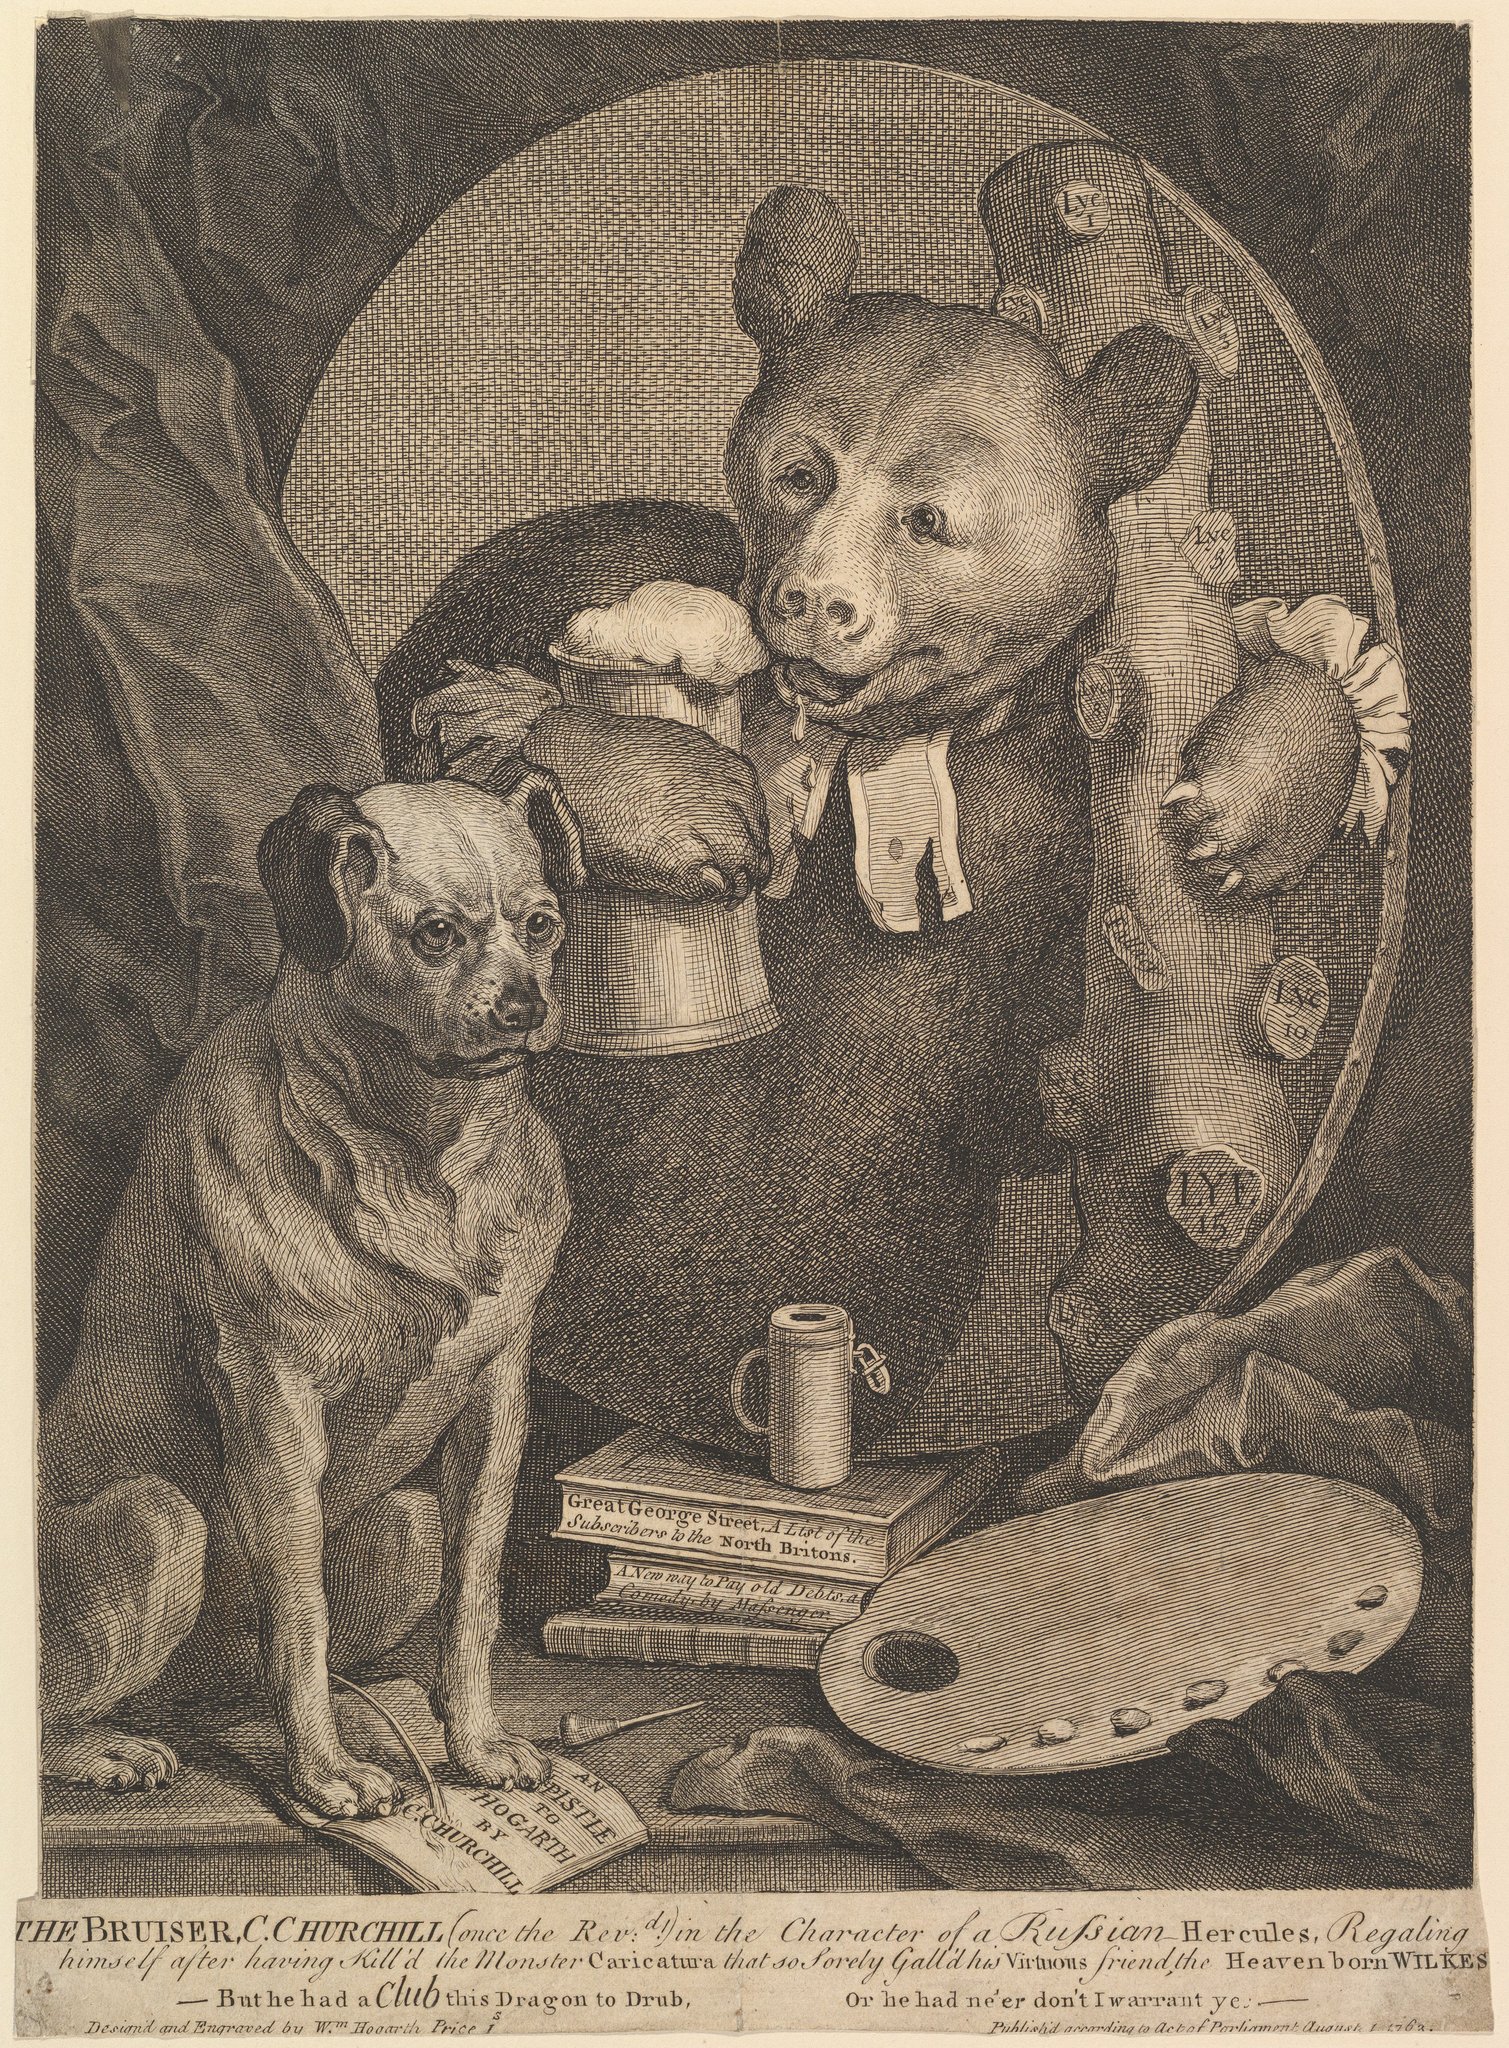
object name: print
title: The Bruiser (Caricature of Charles Churchill)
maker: william hogarth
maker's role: artist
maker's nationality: british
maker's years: 1697-1764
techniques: engraving, etching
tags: bears,books,dogs,drinking,cups,caricature,palettes